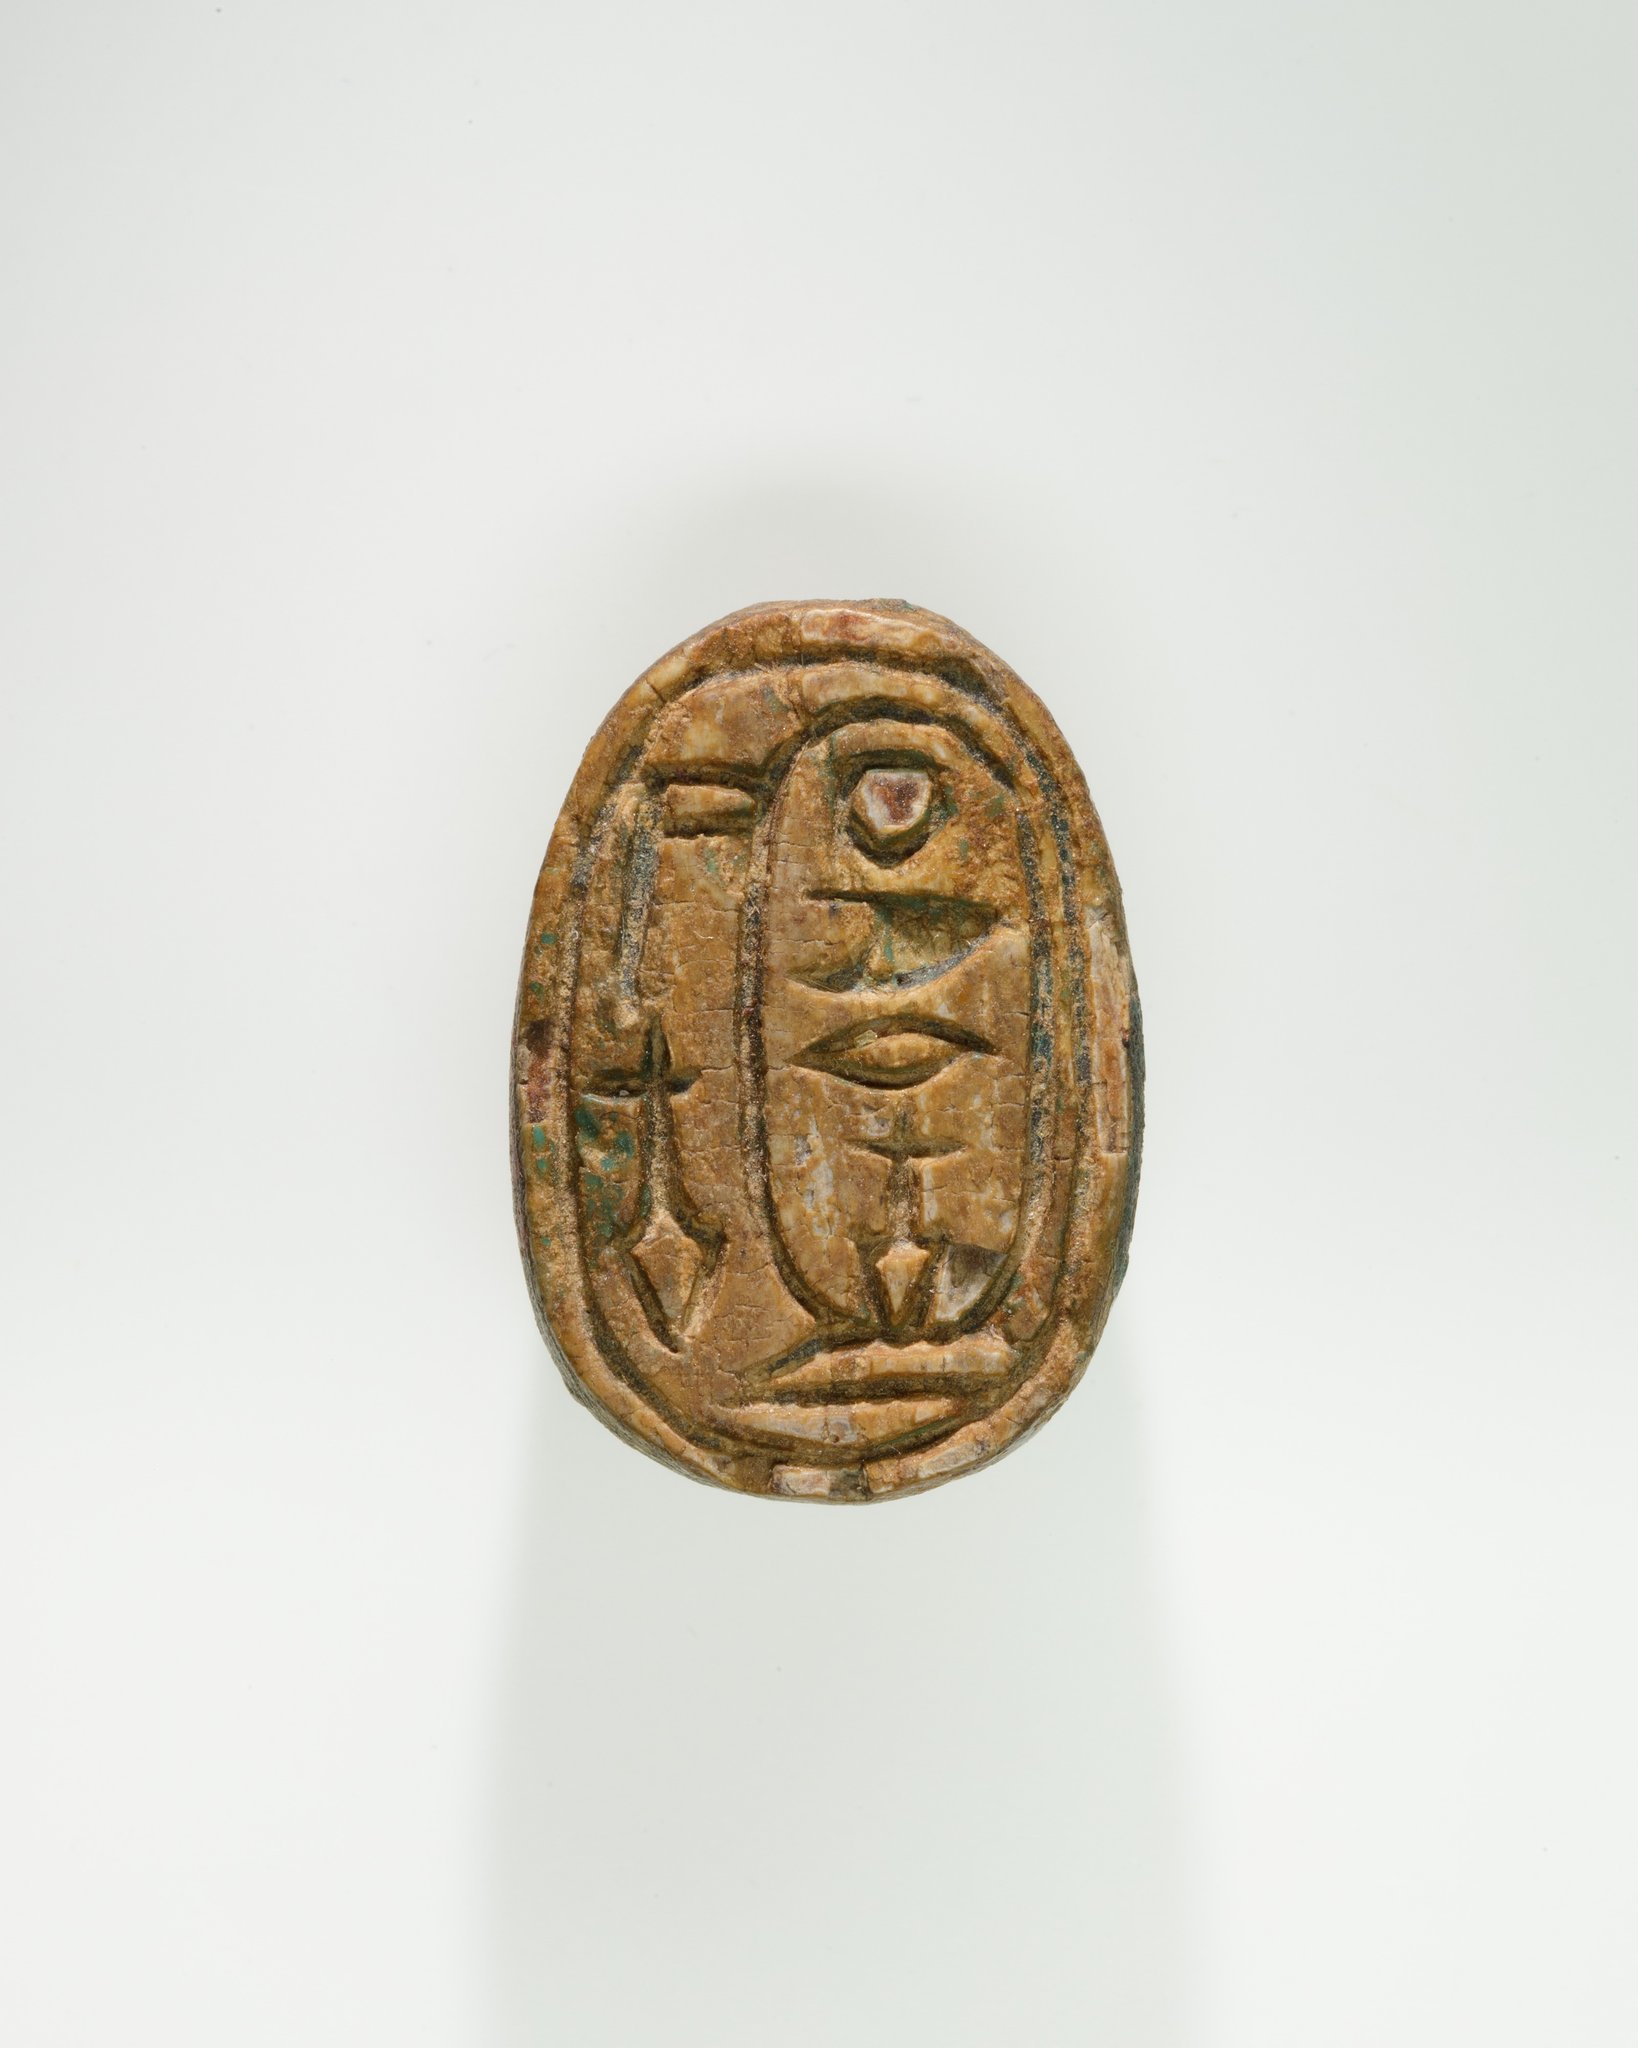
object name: scarab, merneferre aya, good god, cartouche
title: Scarab Inscribed for Pharaoh Aya (I)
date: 1700-1676 BCE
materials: stone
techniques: glazing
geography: egypt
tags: cartouches,hieroglyphs,scarabs